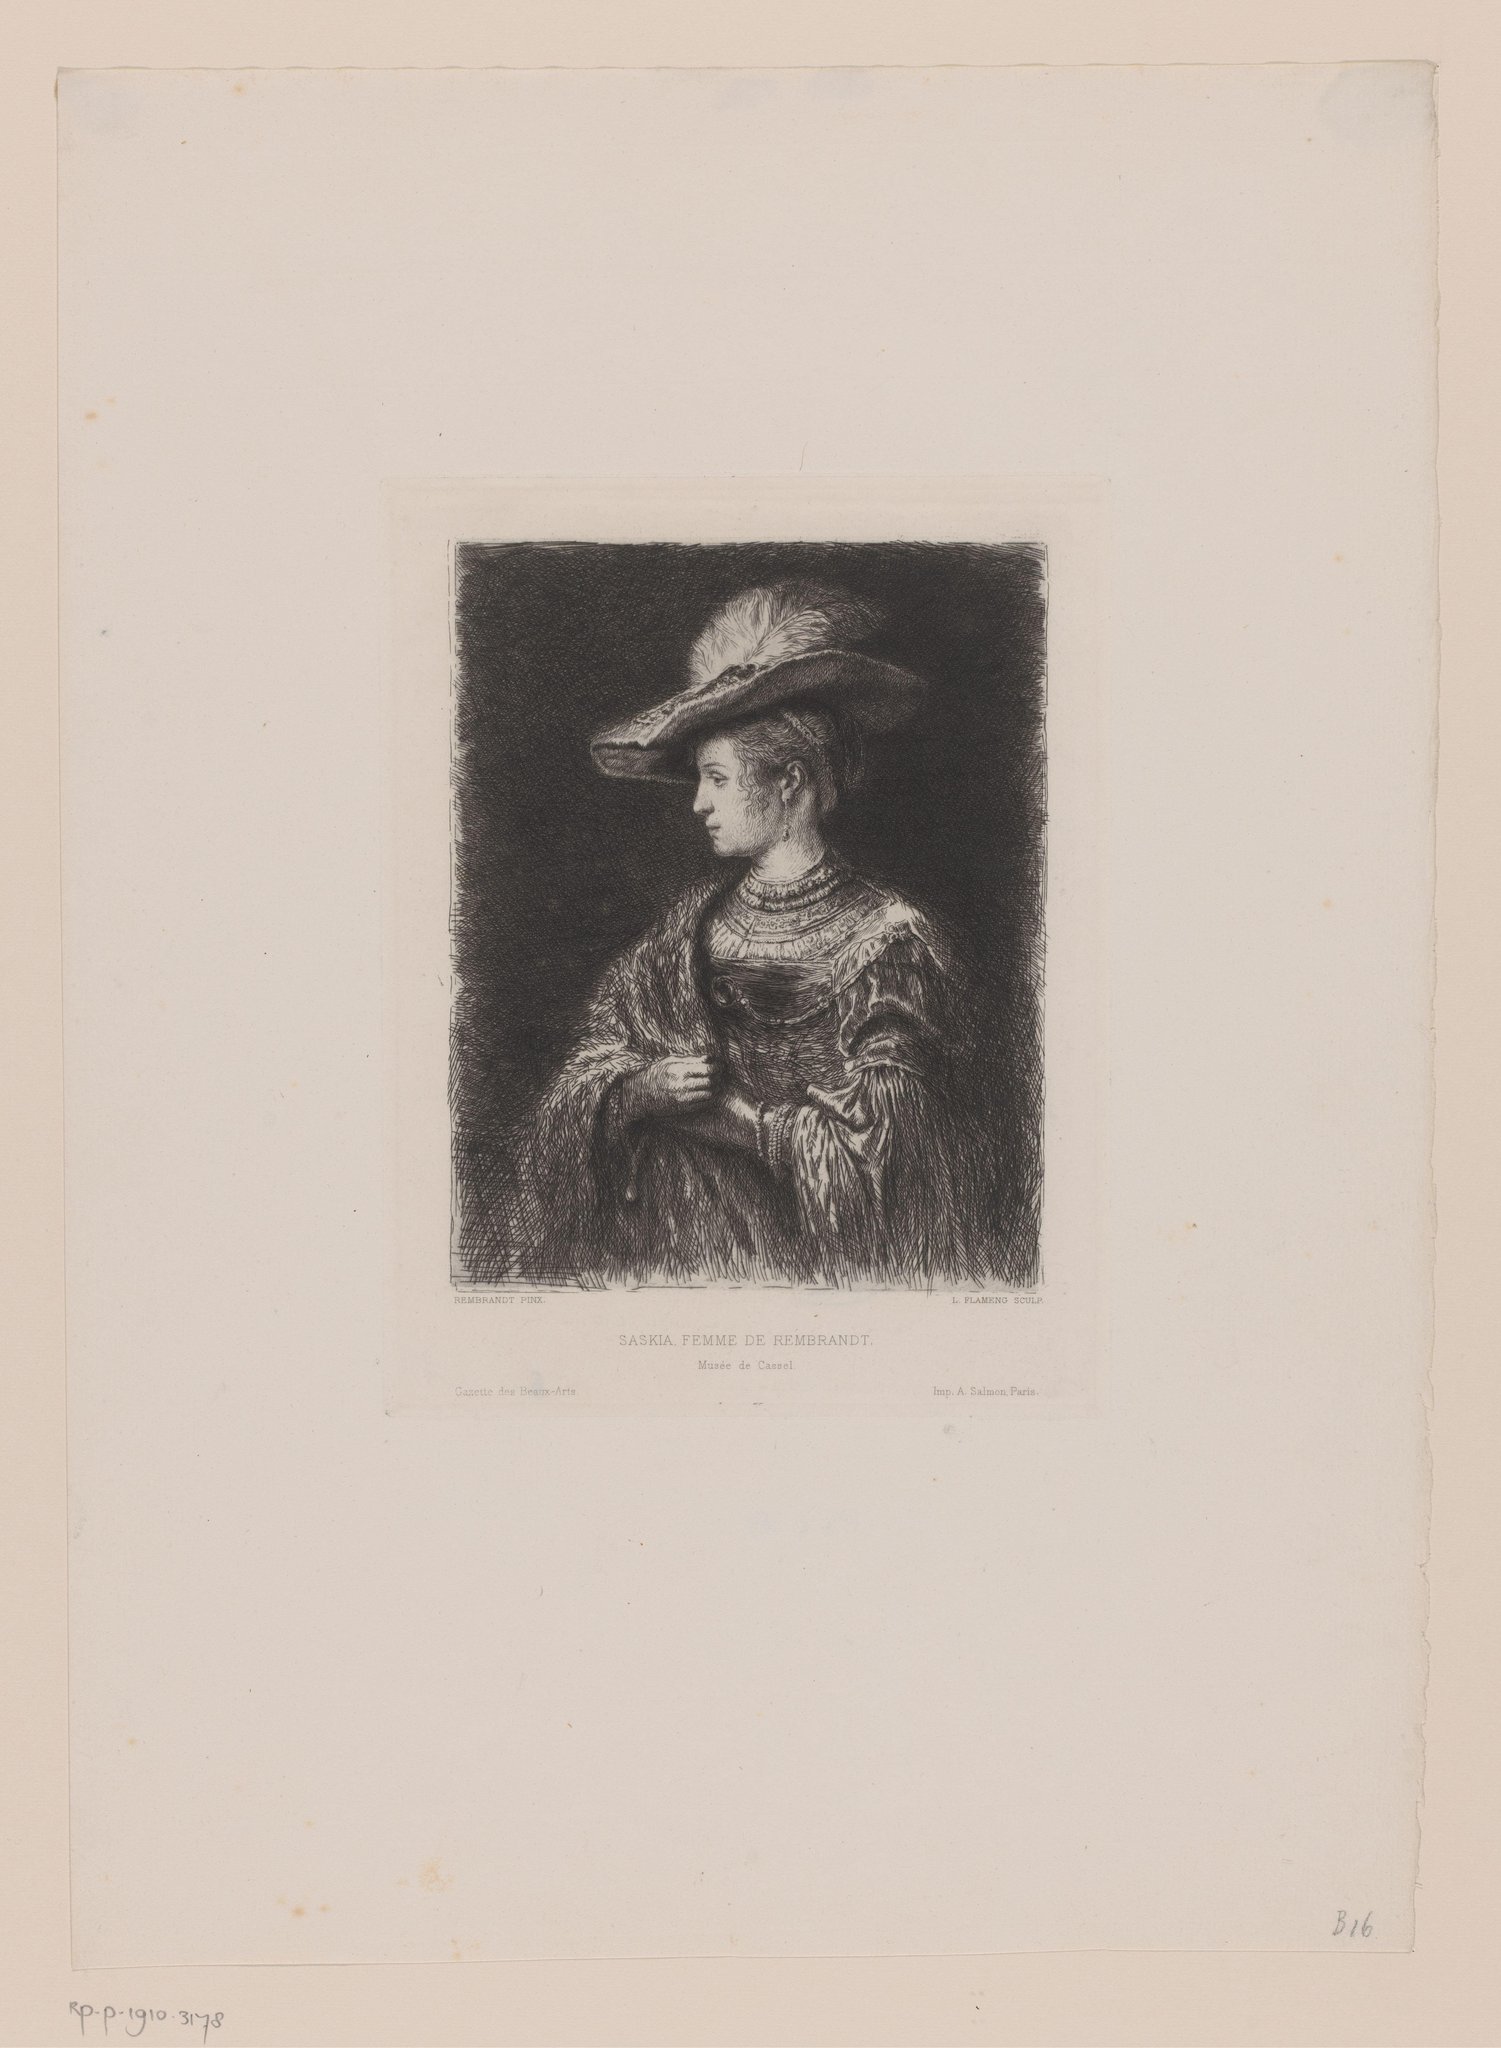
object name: print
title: Portret van Saskia van Uylenburgh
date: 1869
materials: paper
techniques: drypoint, etching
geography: paris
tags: amsterdam, historical persons - bb - woman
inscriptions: collector's mark: Lugt 2228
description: Prent uit: Gazette des beaux-arts (1869), 1 oktober 1869, p. 294-295.